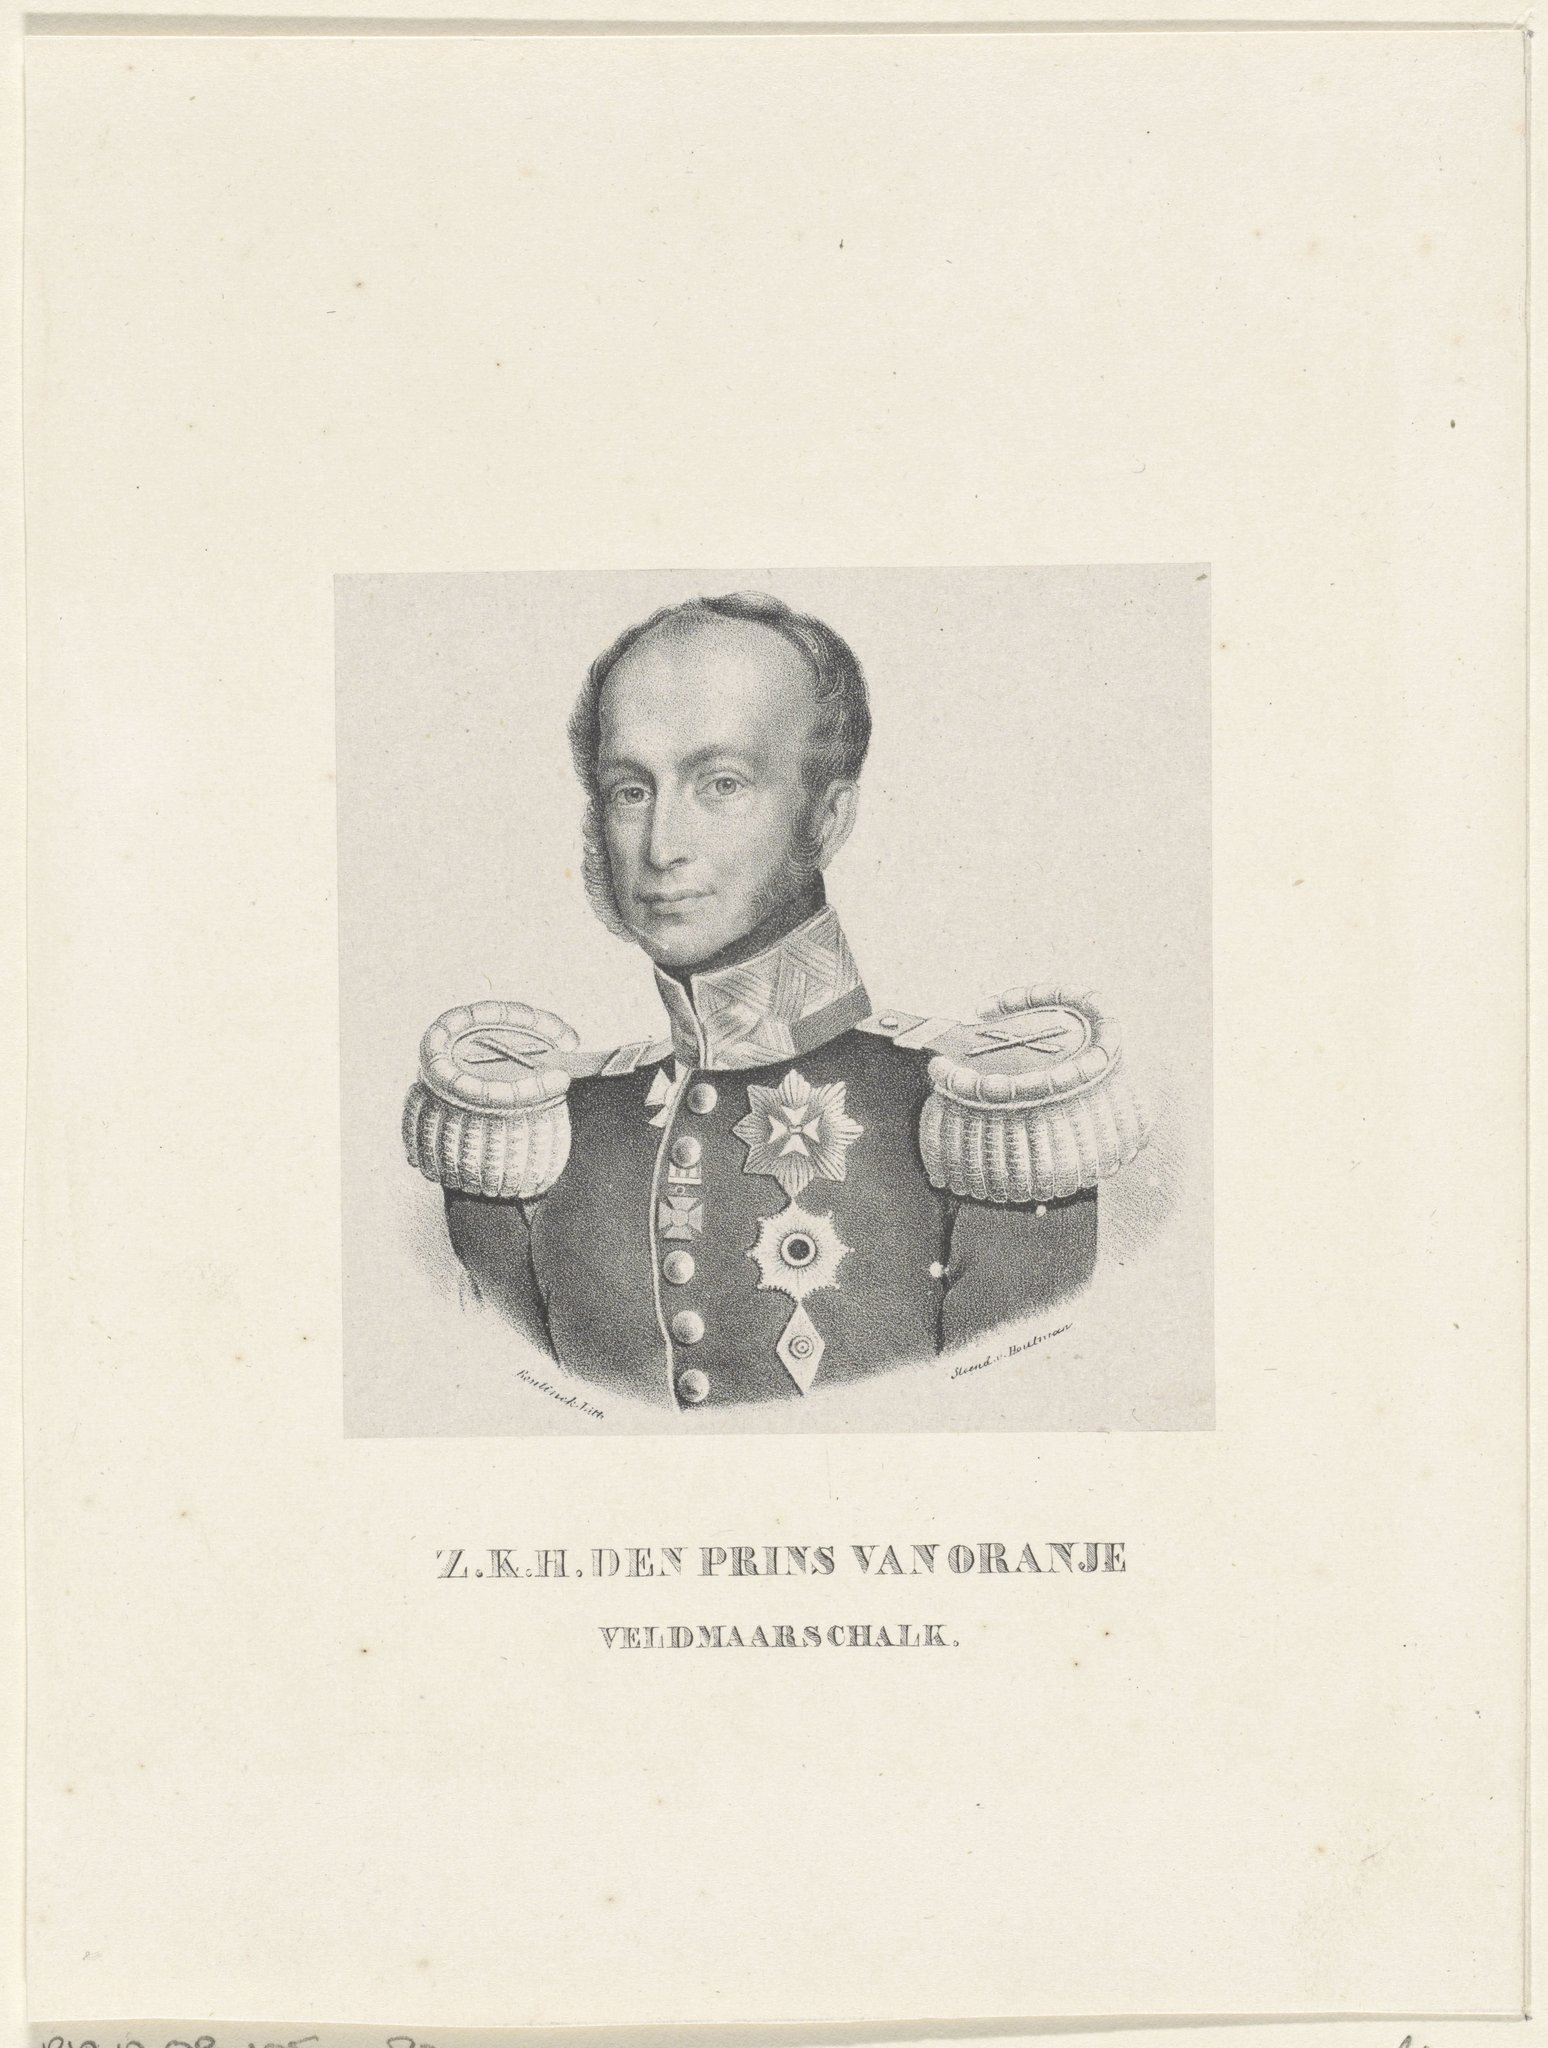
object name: titelblad, titelpagina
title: Titelpagina voor: J.F. van Someren, Oude kunst in Nederland : etsen van Wilm. Steelink, naar schilderijen uit de kabinetten van A. Bredius, A.J. Enschedé, J.P. Six, P.H. Six, H.A. Steengracht van Duivenvoorde, Victor de Stuers en andere verzamelingen, Amsterdam 1888-1891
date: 1888-1891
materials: paper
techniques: letterpress printing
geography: amsterdam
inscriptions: collector's mark: Lugt 2166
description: Titelpagina voor: J.F. van Someren, Oude kunst in Nederland : etsen van Wilm. Steelink, naar schilderijen uit de kabinetten van A. Bredius, A.J. Enschedé, J.P. Six, P.H. Six H.A. Steengracht van Duivenvoorde, Victor de Stuers en andere verzamelingen, Amsterdam 1888-1891.